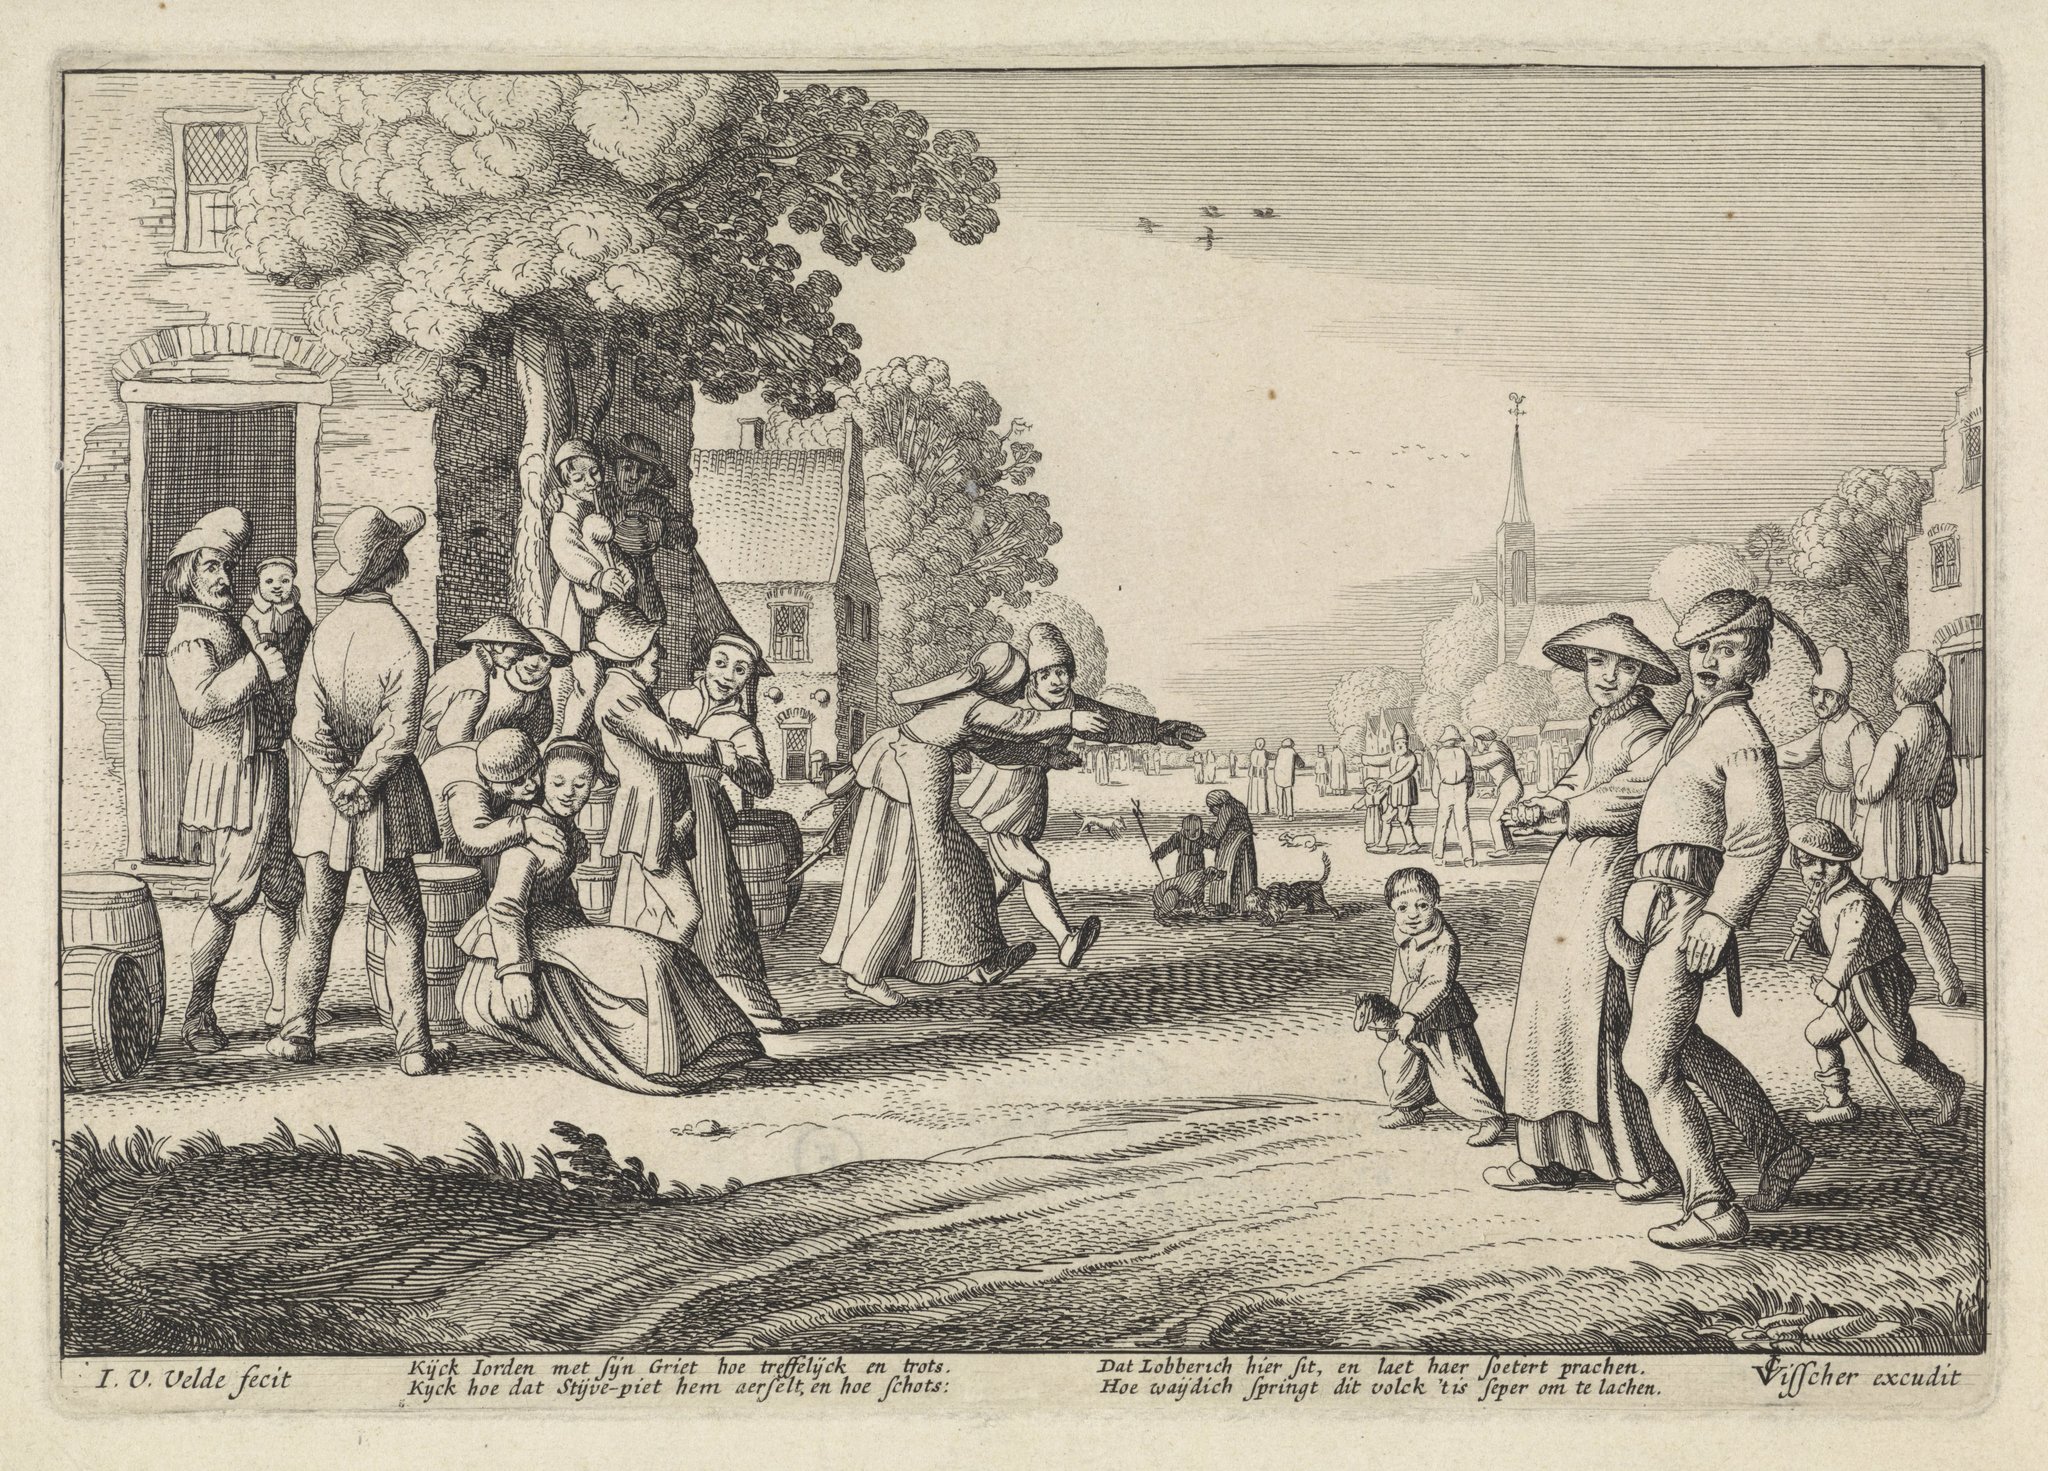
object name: print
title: Dansende boeren tijdens een dorpsfeest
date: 1603-1652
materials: paper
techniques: etching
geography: northern netherlands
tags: farmers, performance in the open air (pleasure fair), bagpipe, musette - cc - out of doors, more than one couple dancing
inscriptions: poem: ‘Kijck Iorden met sijn Griet hoe treffelijck en trots./Kijck hoe dat Stijve-piet hem aerselt, en hoe schots:/Dat Lobberich hier sit, en laet haer soetert prachen./Hoe waedijch springt dit volck 't is seper om te lachen.’, signature: ‘I.V. Velde fecit’, collector's mark: Lugt 964, address: ‘CJVisscher’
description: Dansende boeren paren in een dorpsstraat, tijdens een dorpsfeest, op de muziek van een doedelzakspeler die onder een boom staat te spelen. Rechtsvoor een jongetje op een stokpaardje. Rechts op de achtergrond een kerk.